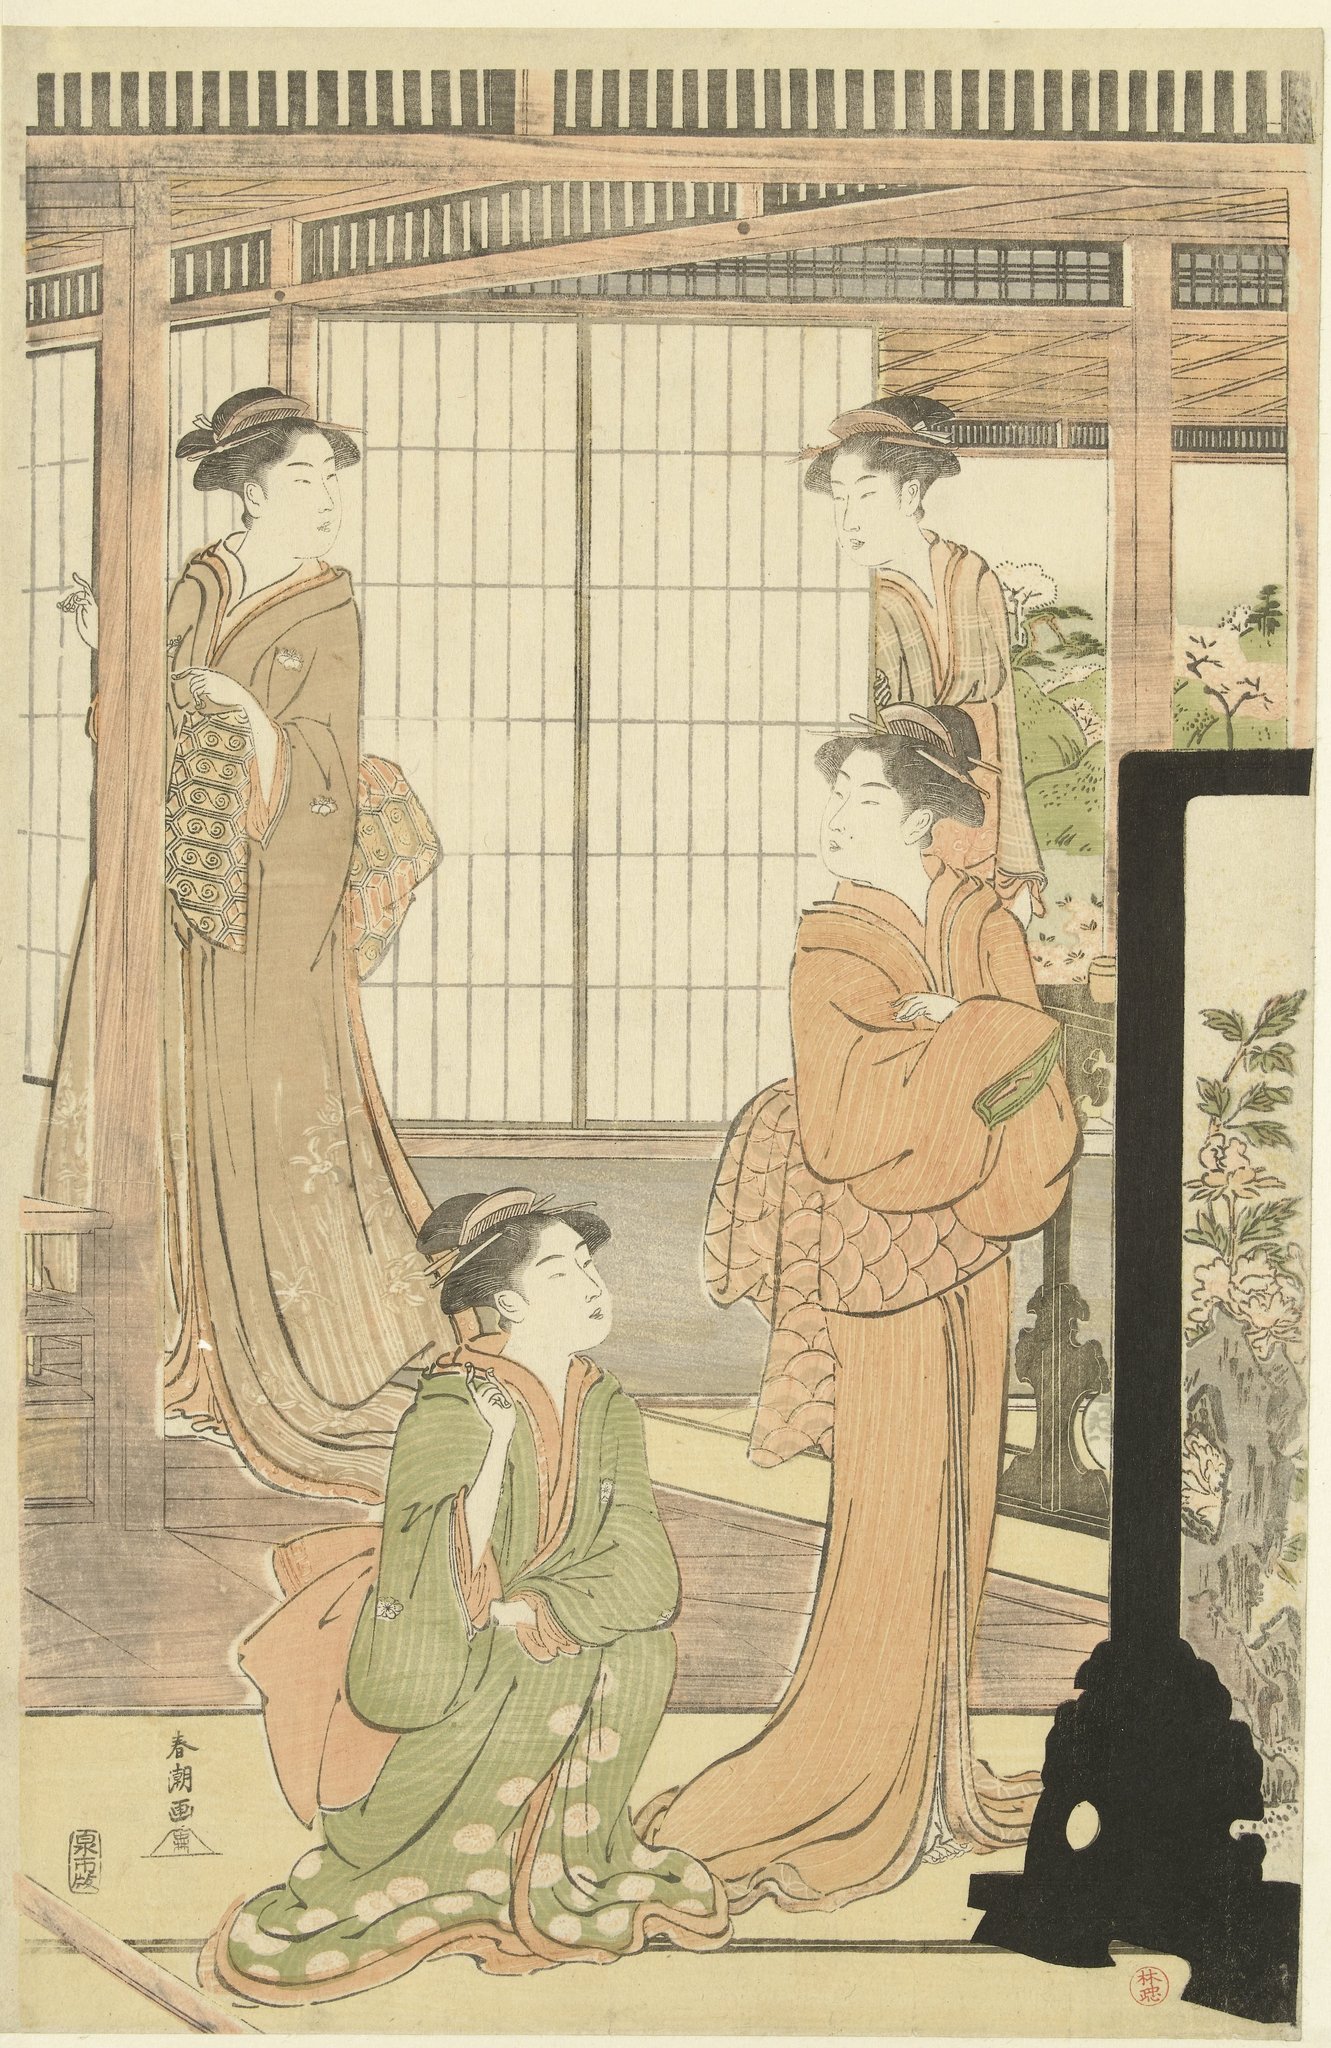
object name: print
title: Voorbereidingen voor het poppenfeest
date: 1785-1800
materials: paper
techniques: woodcut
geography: tokyo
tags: adult woman (+ four persons), interior of the house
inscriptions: collector's mark: Lugt 2971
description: Vier vrouwen in een kamer met op de achtergrond uitzicht op tuin met bloesemende bomen.